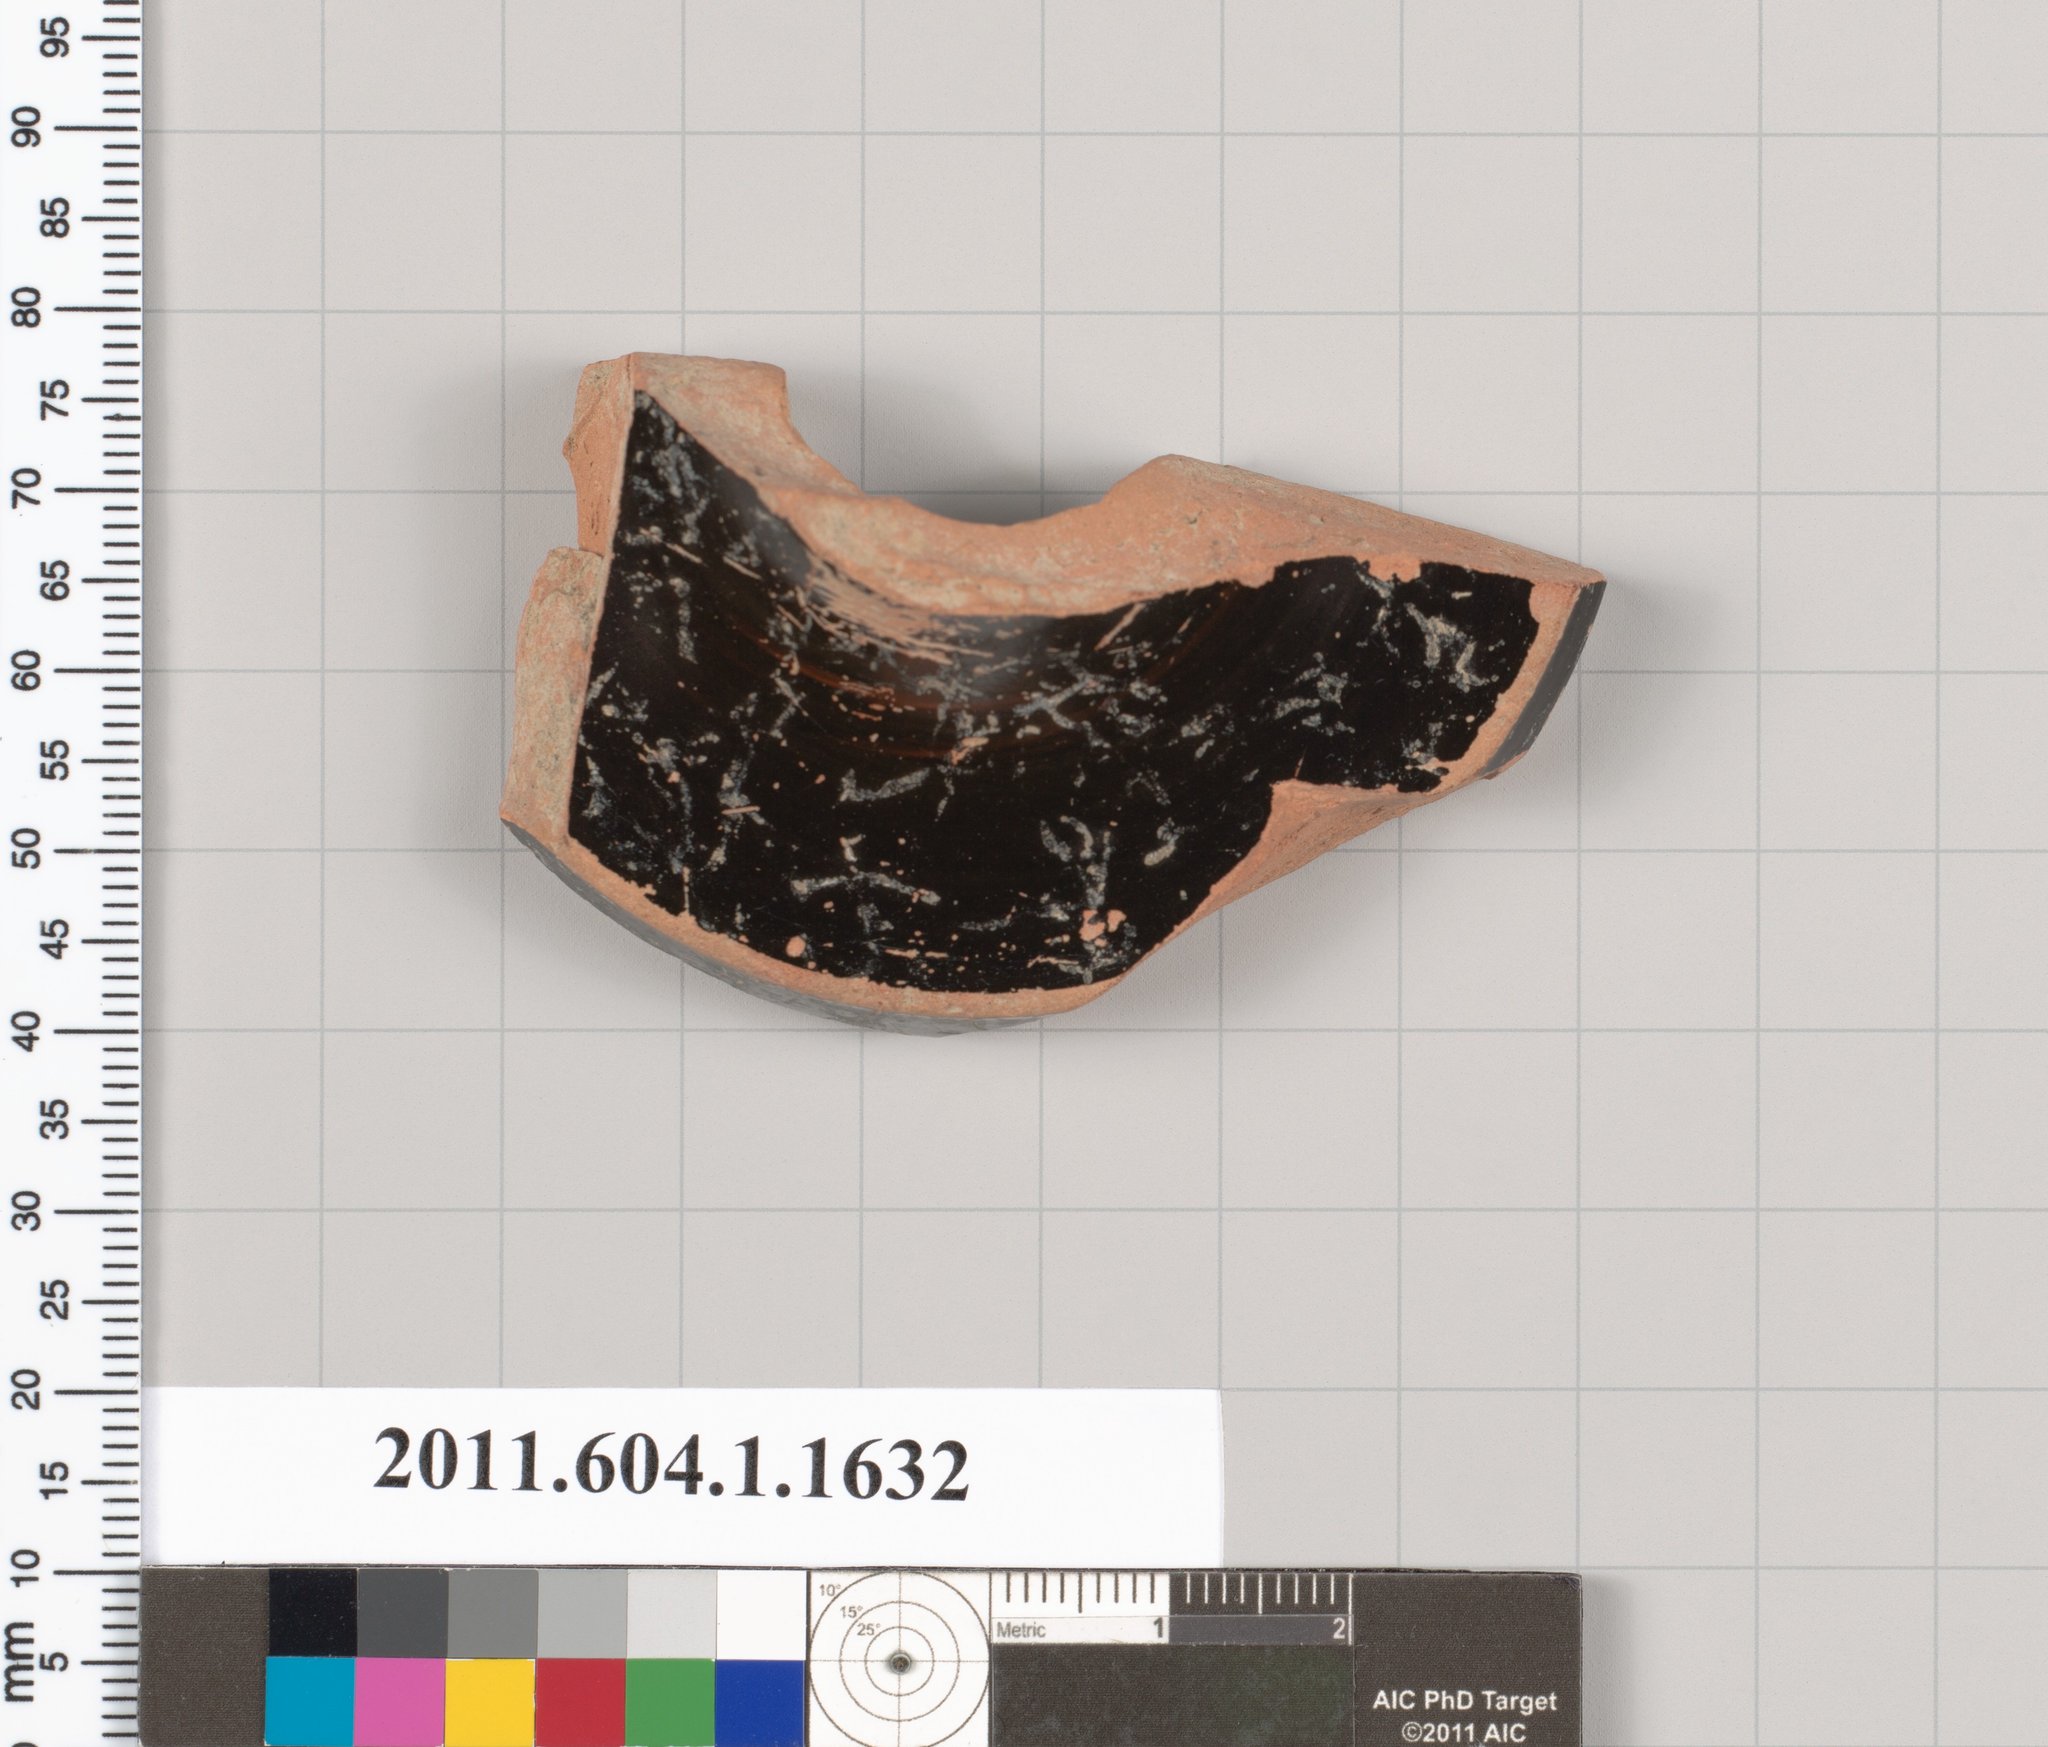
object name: kylix fragment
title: Terracotta fragment of a kylix (drinking cup)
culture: greek, attic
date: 500-401 BCE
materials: terracotta